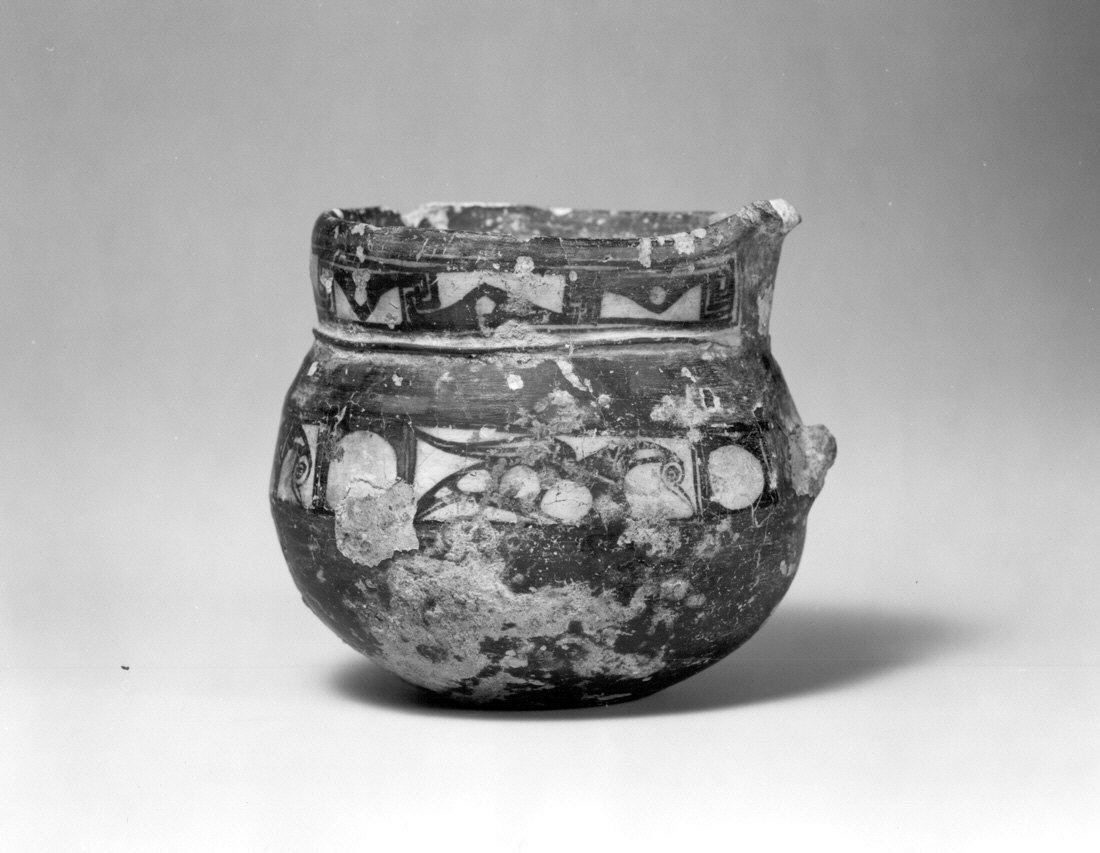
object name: vessel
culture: graeco-bactrian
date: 300-201 BCE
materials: ceramic, paint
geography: central asia